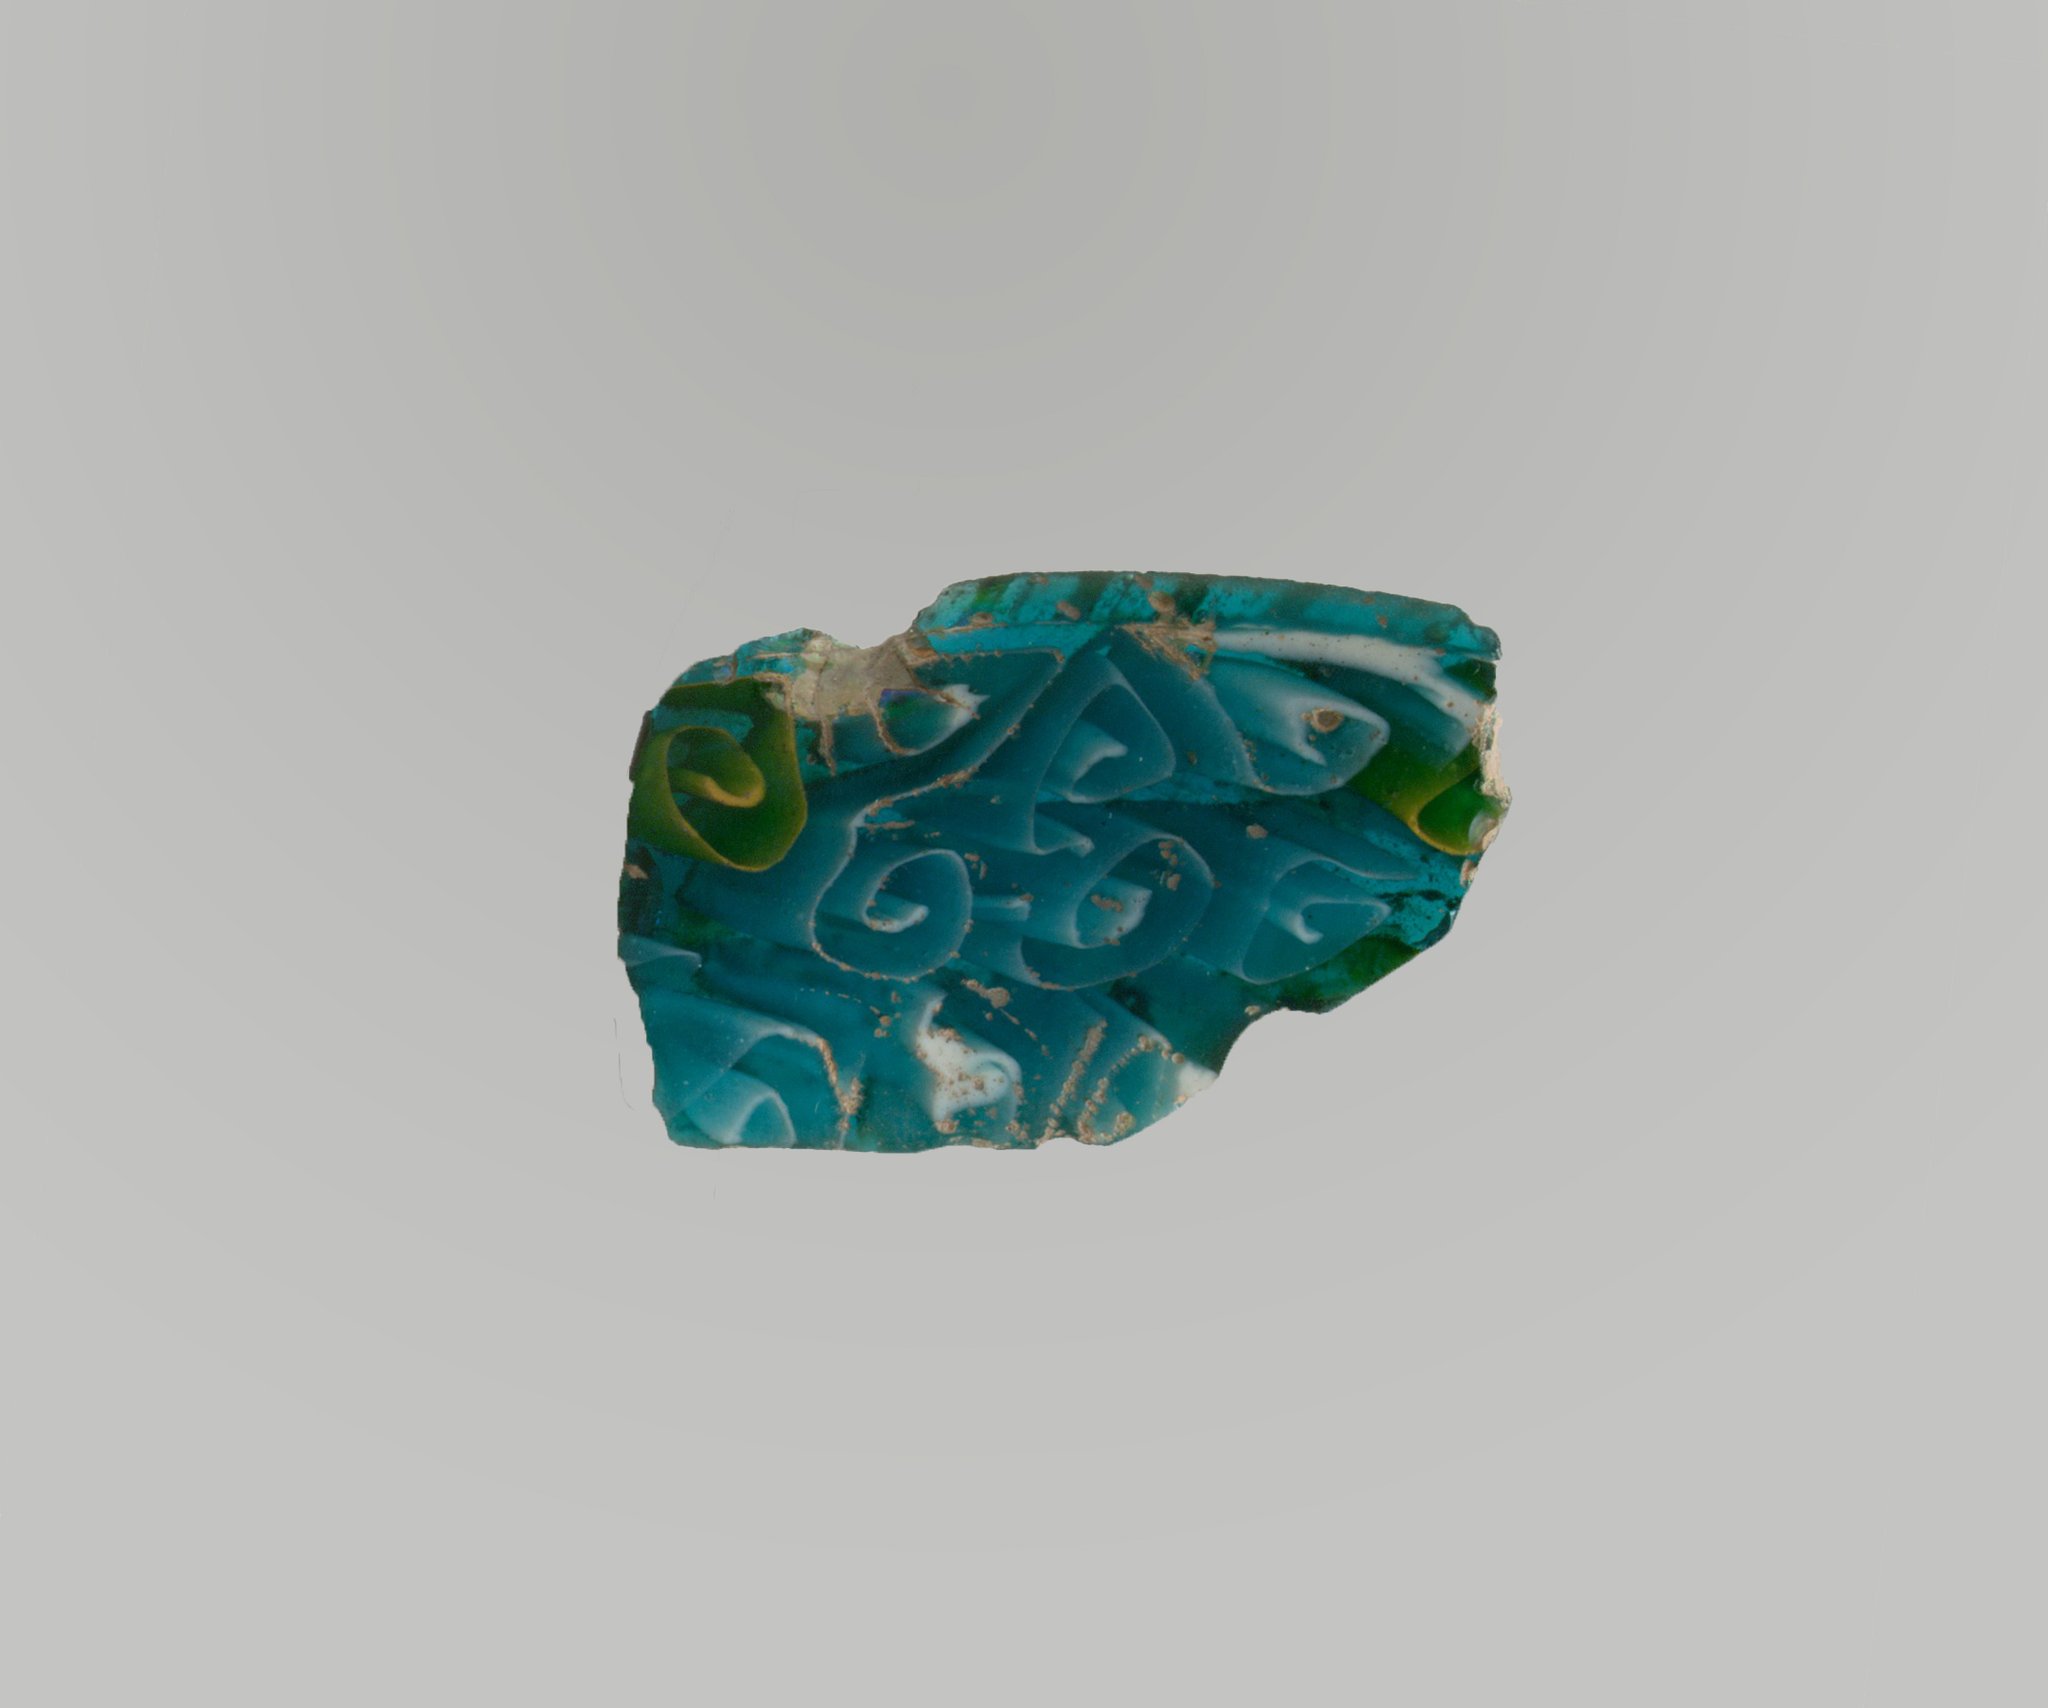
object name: fragment, mosaic dish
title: Glass mosaic dish fragment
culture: greek, eastern mediterranean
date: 200-35 BCE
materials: glass